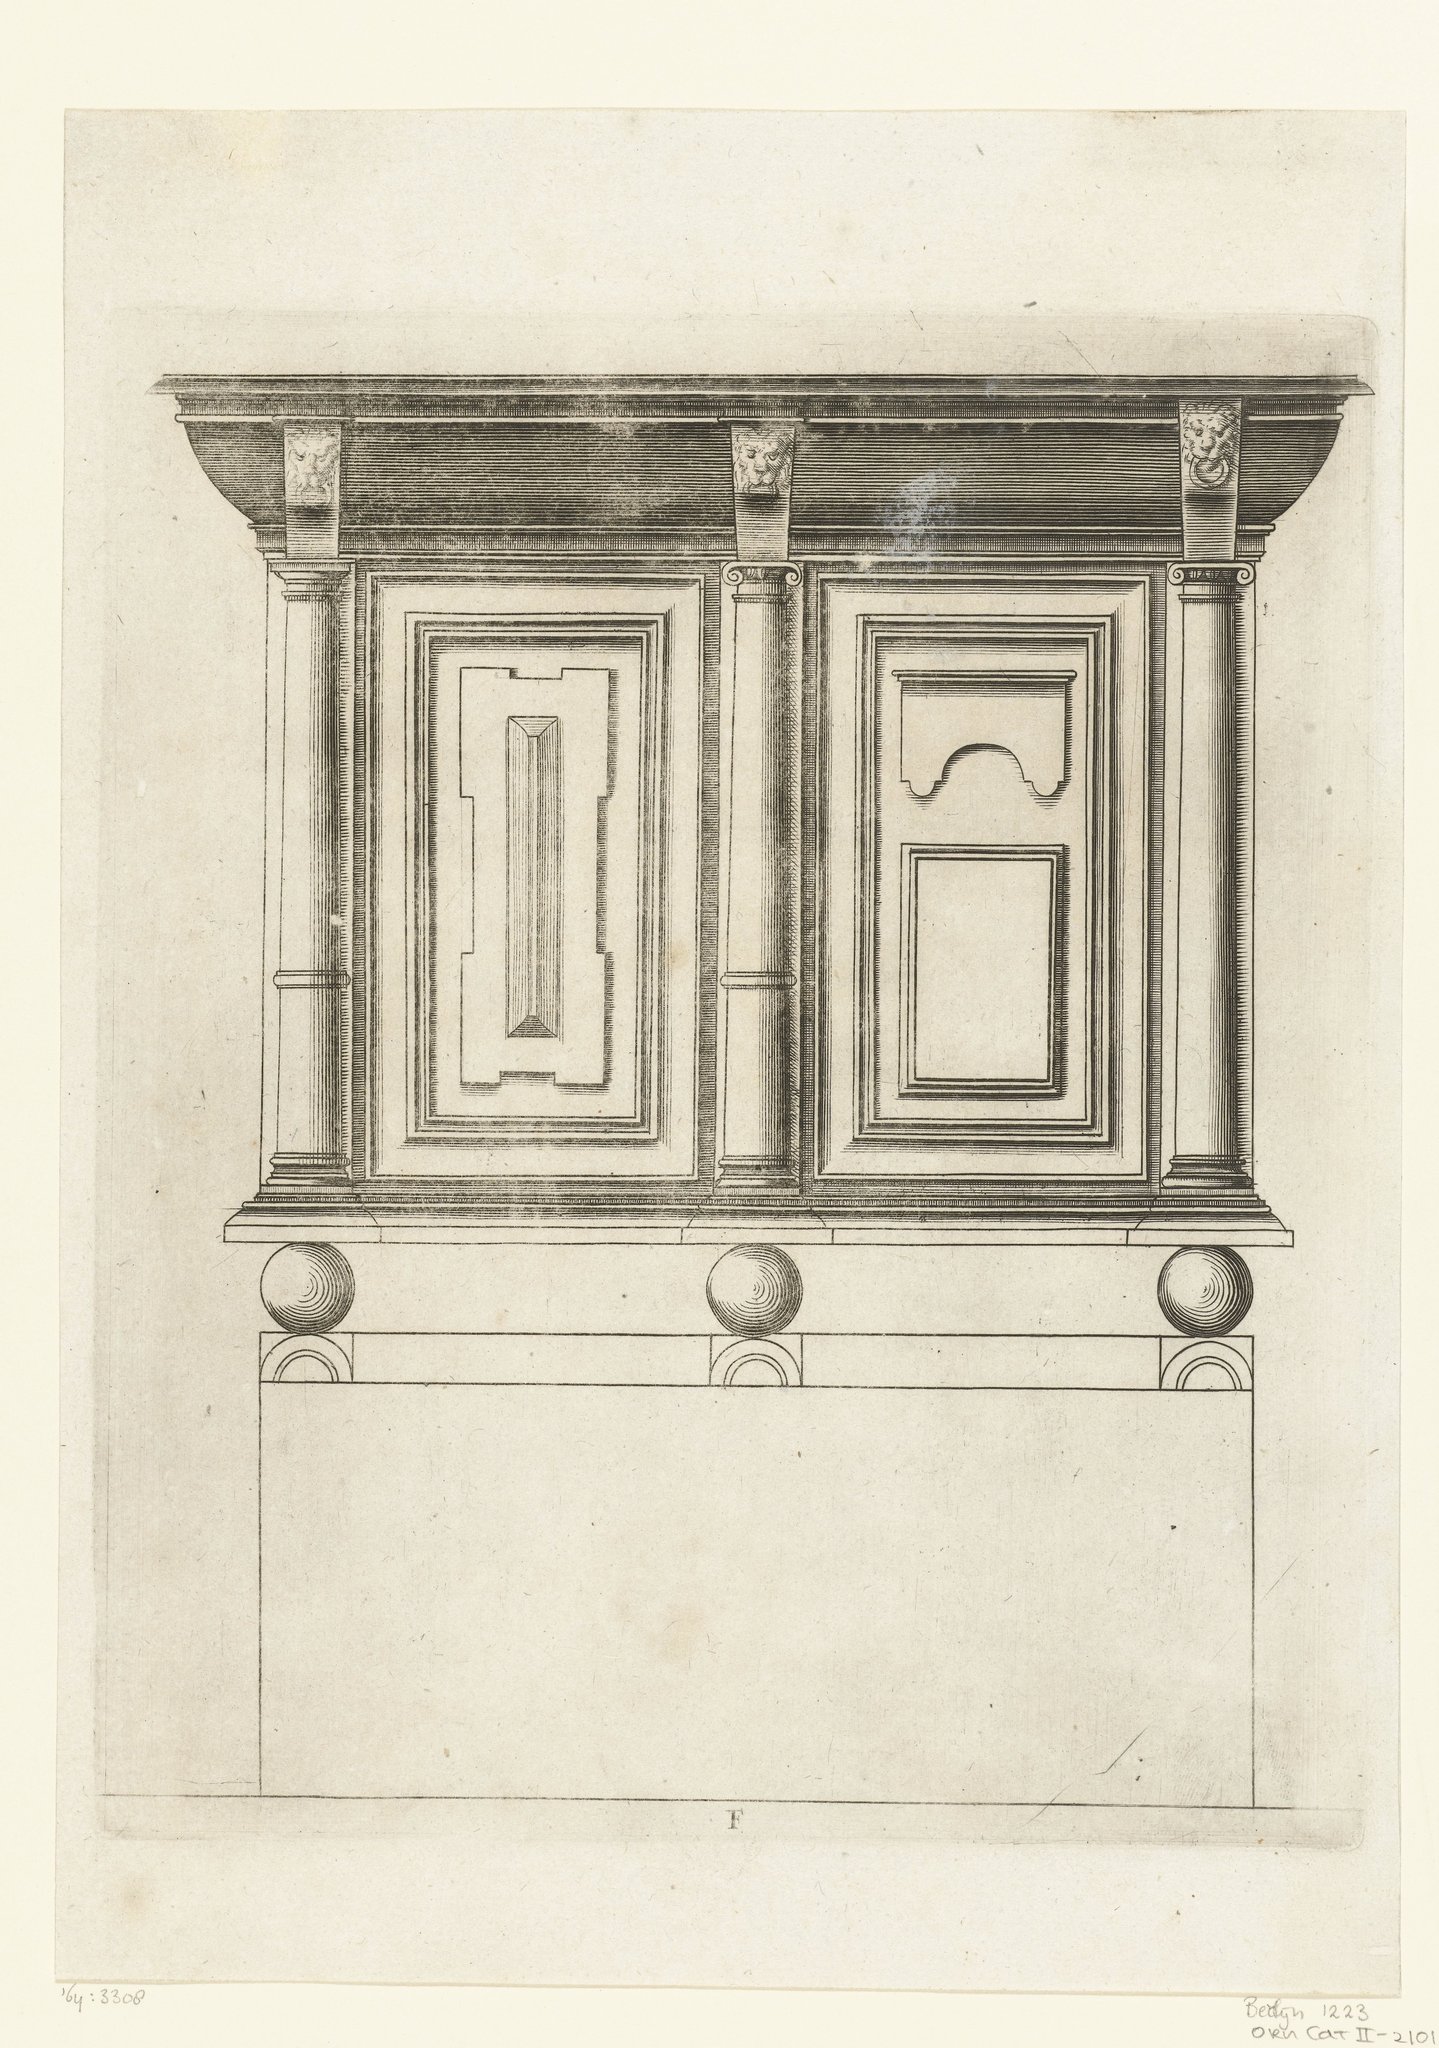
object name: ornament print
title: Buffetkast op ronde poten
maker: Anonymous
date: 1642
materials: paper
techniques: engraving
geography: amsterdam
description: Met een variant voor de decoratie van de rechterhelft, inclusief Toscaanse en Ionische zuilen.